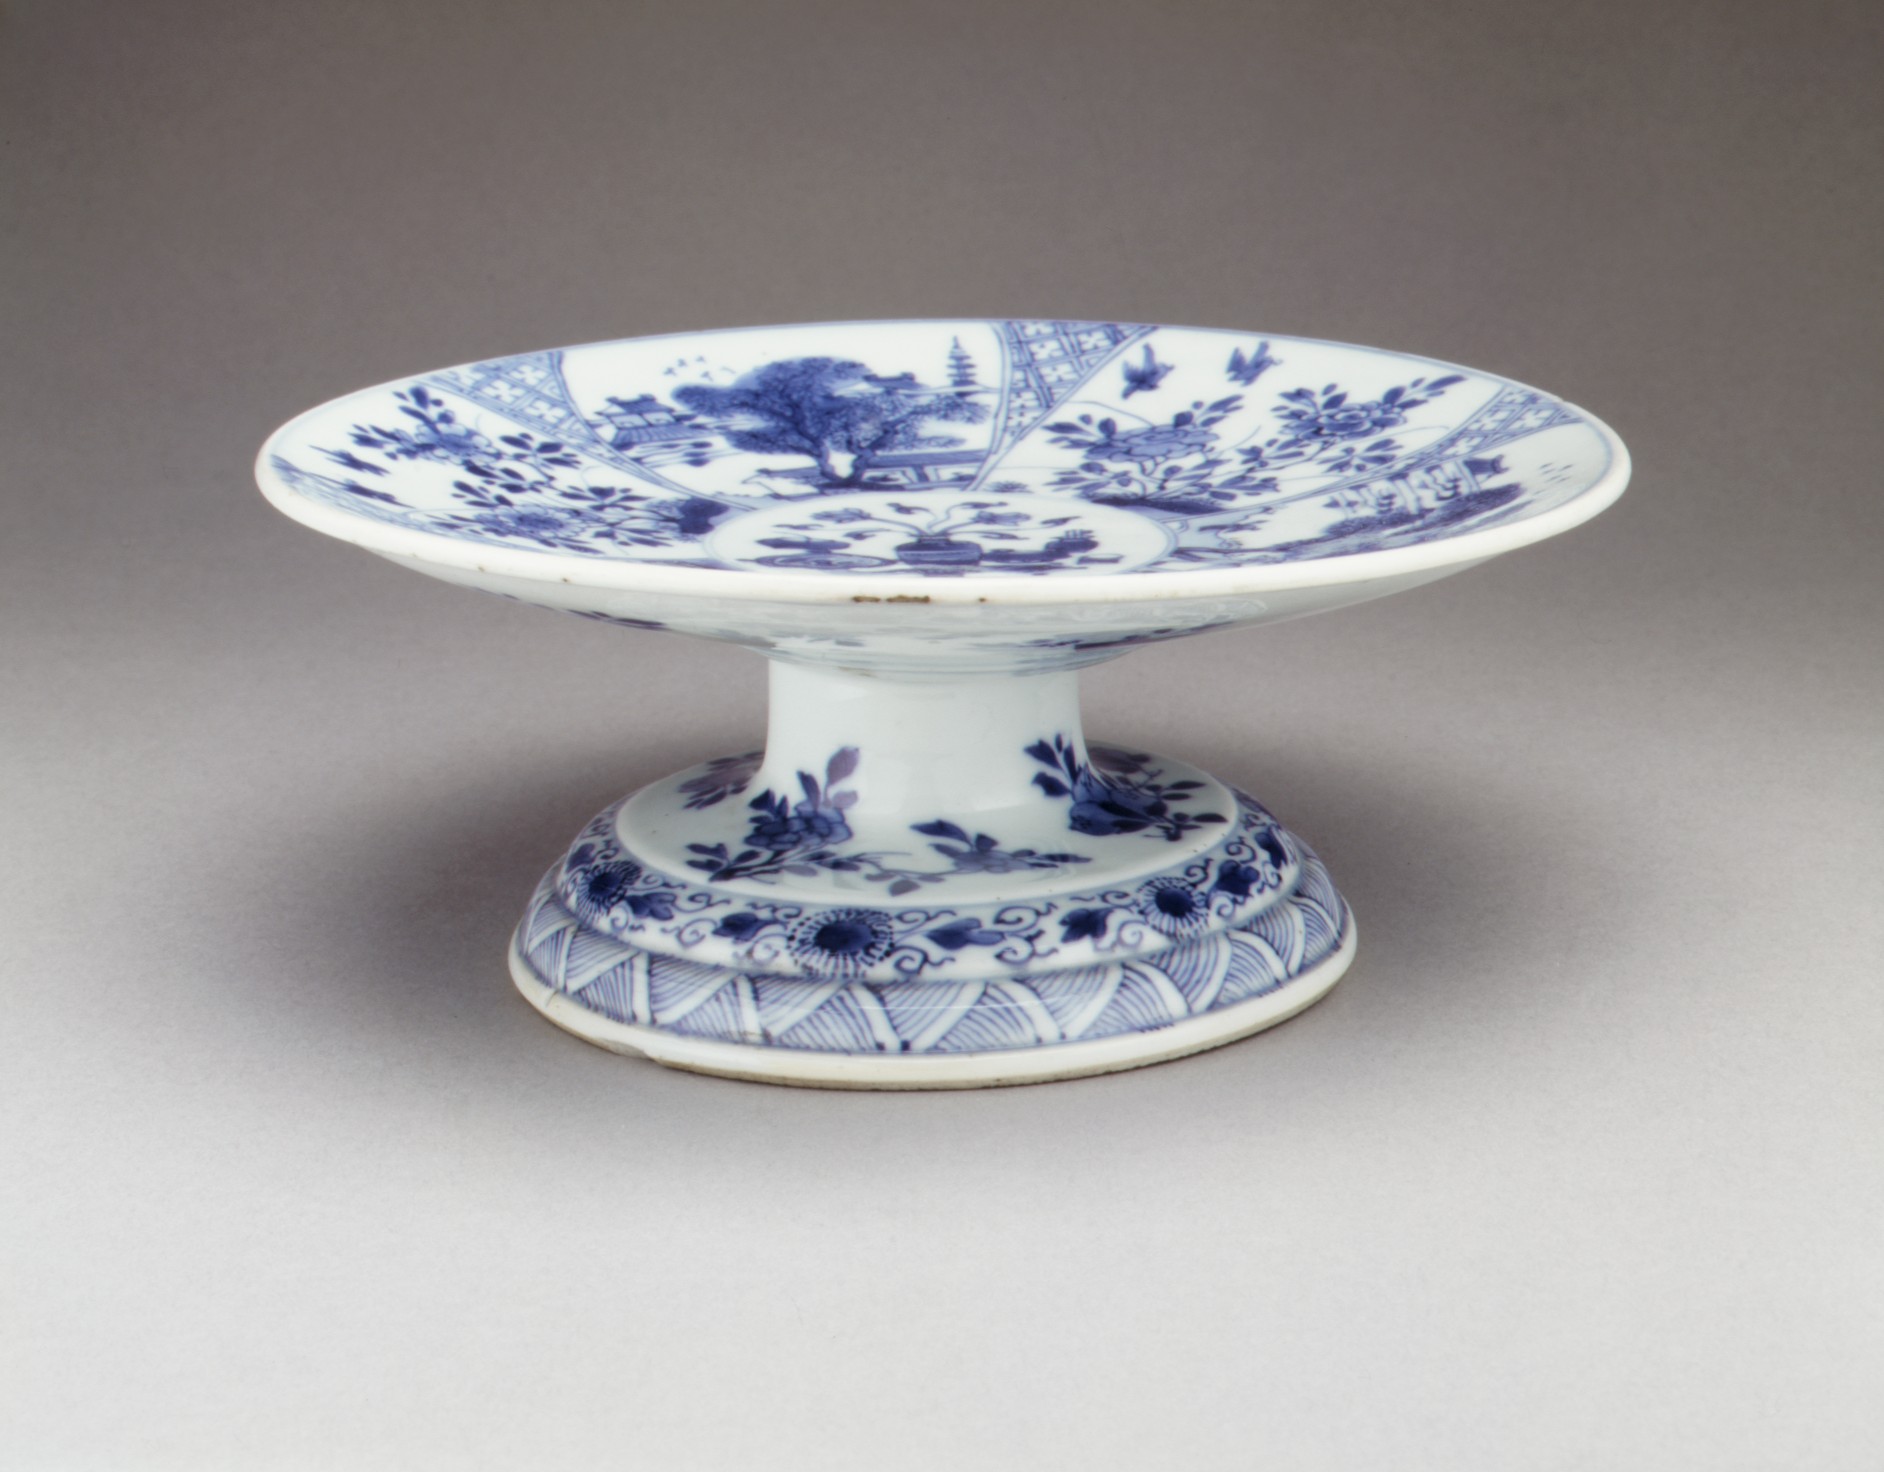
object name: standing dish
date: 1695-1710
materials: porcelain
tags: flowers,trees